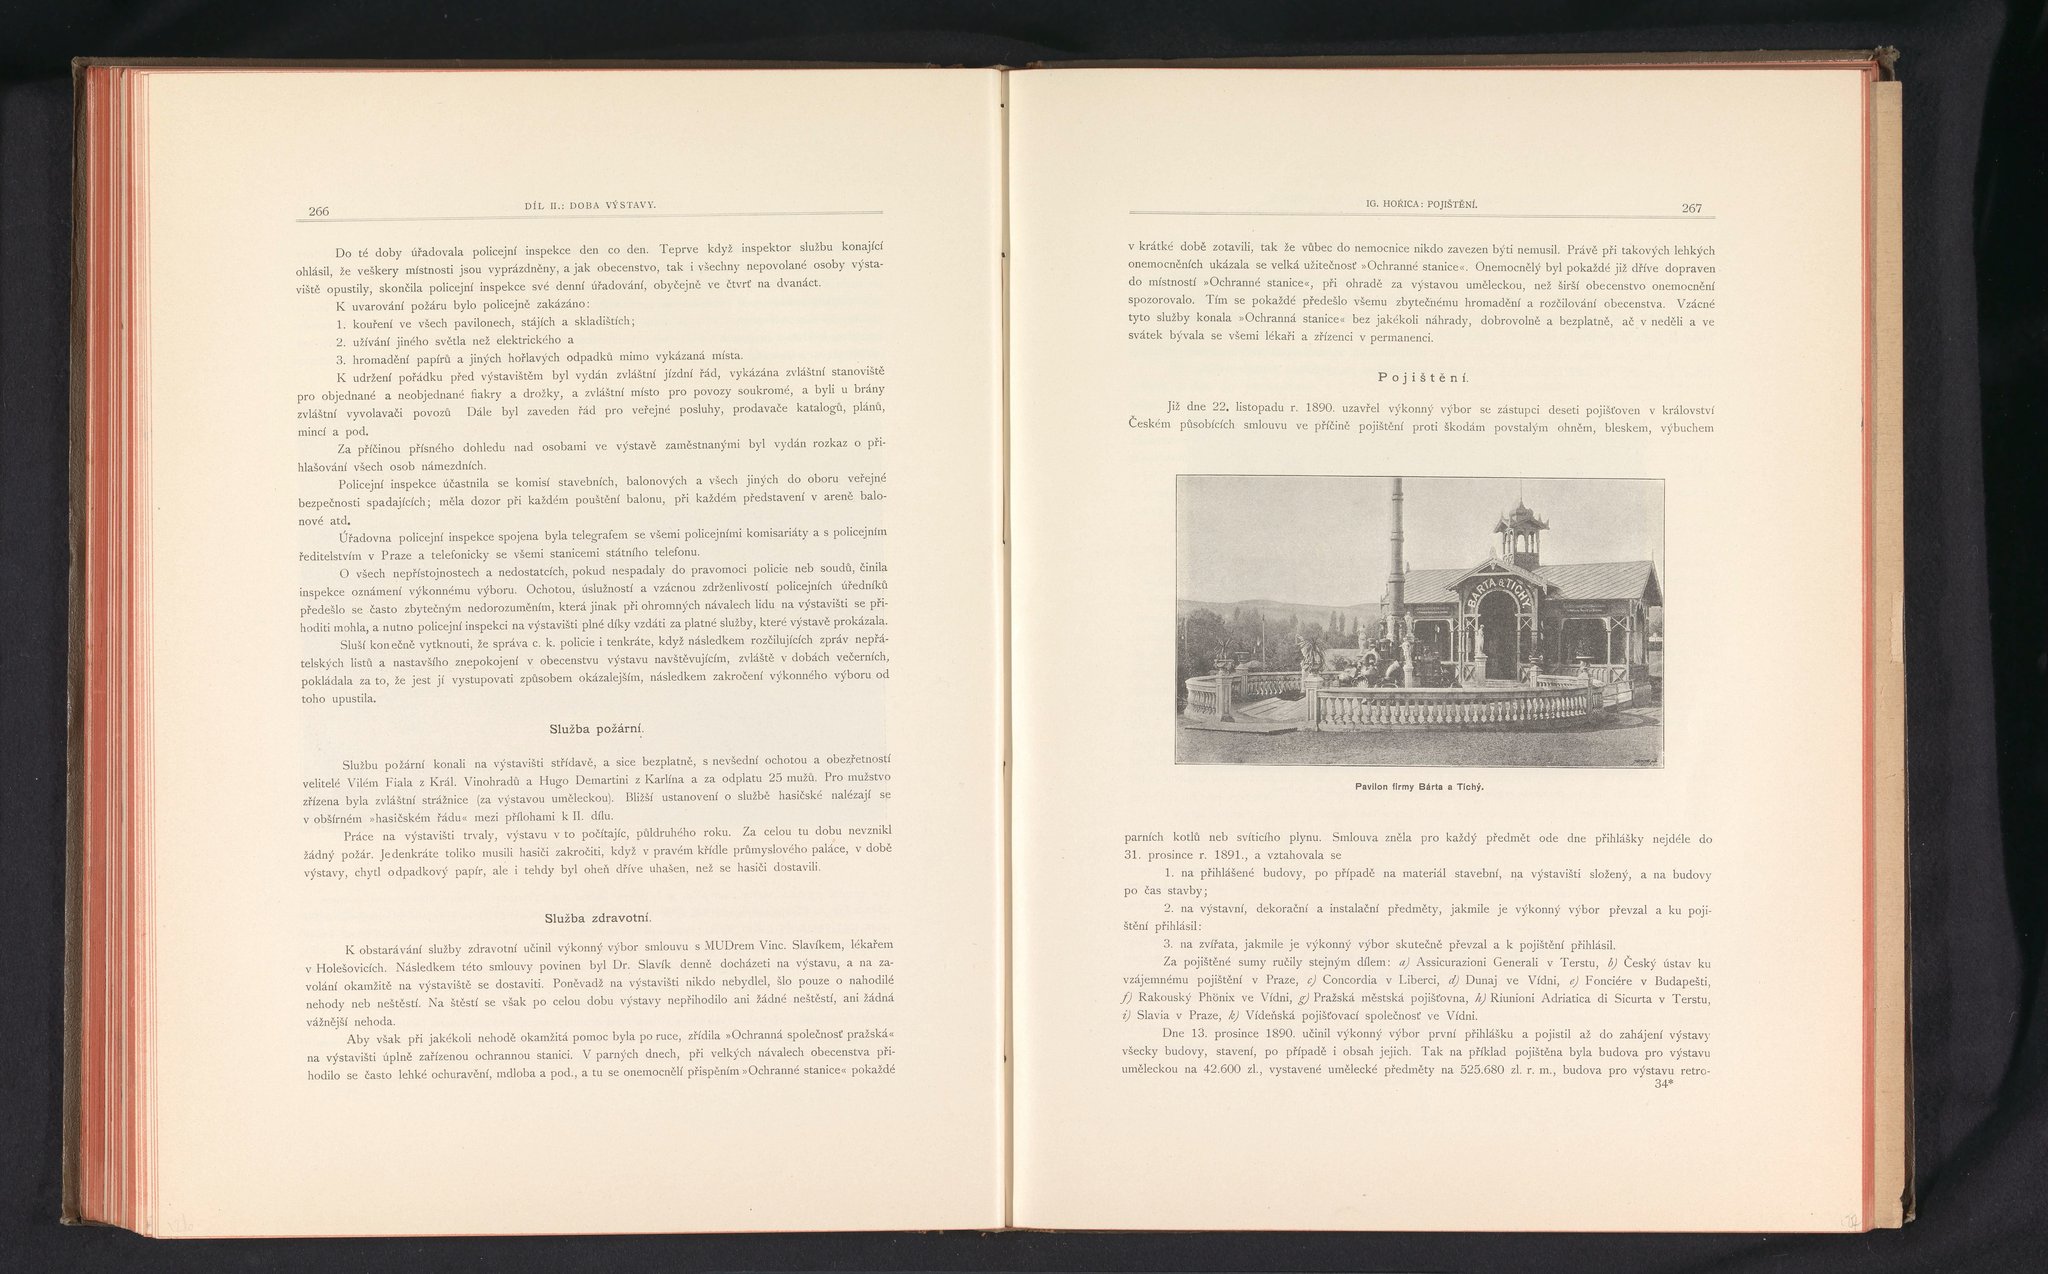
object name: page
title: Pavilon firmy Bárta a Tichý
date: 1891-1893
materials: paper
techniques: autotype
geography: výstaviště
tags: trade exhibition, industries fair, façade (of house or building)